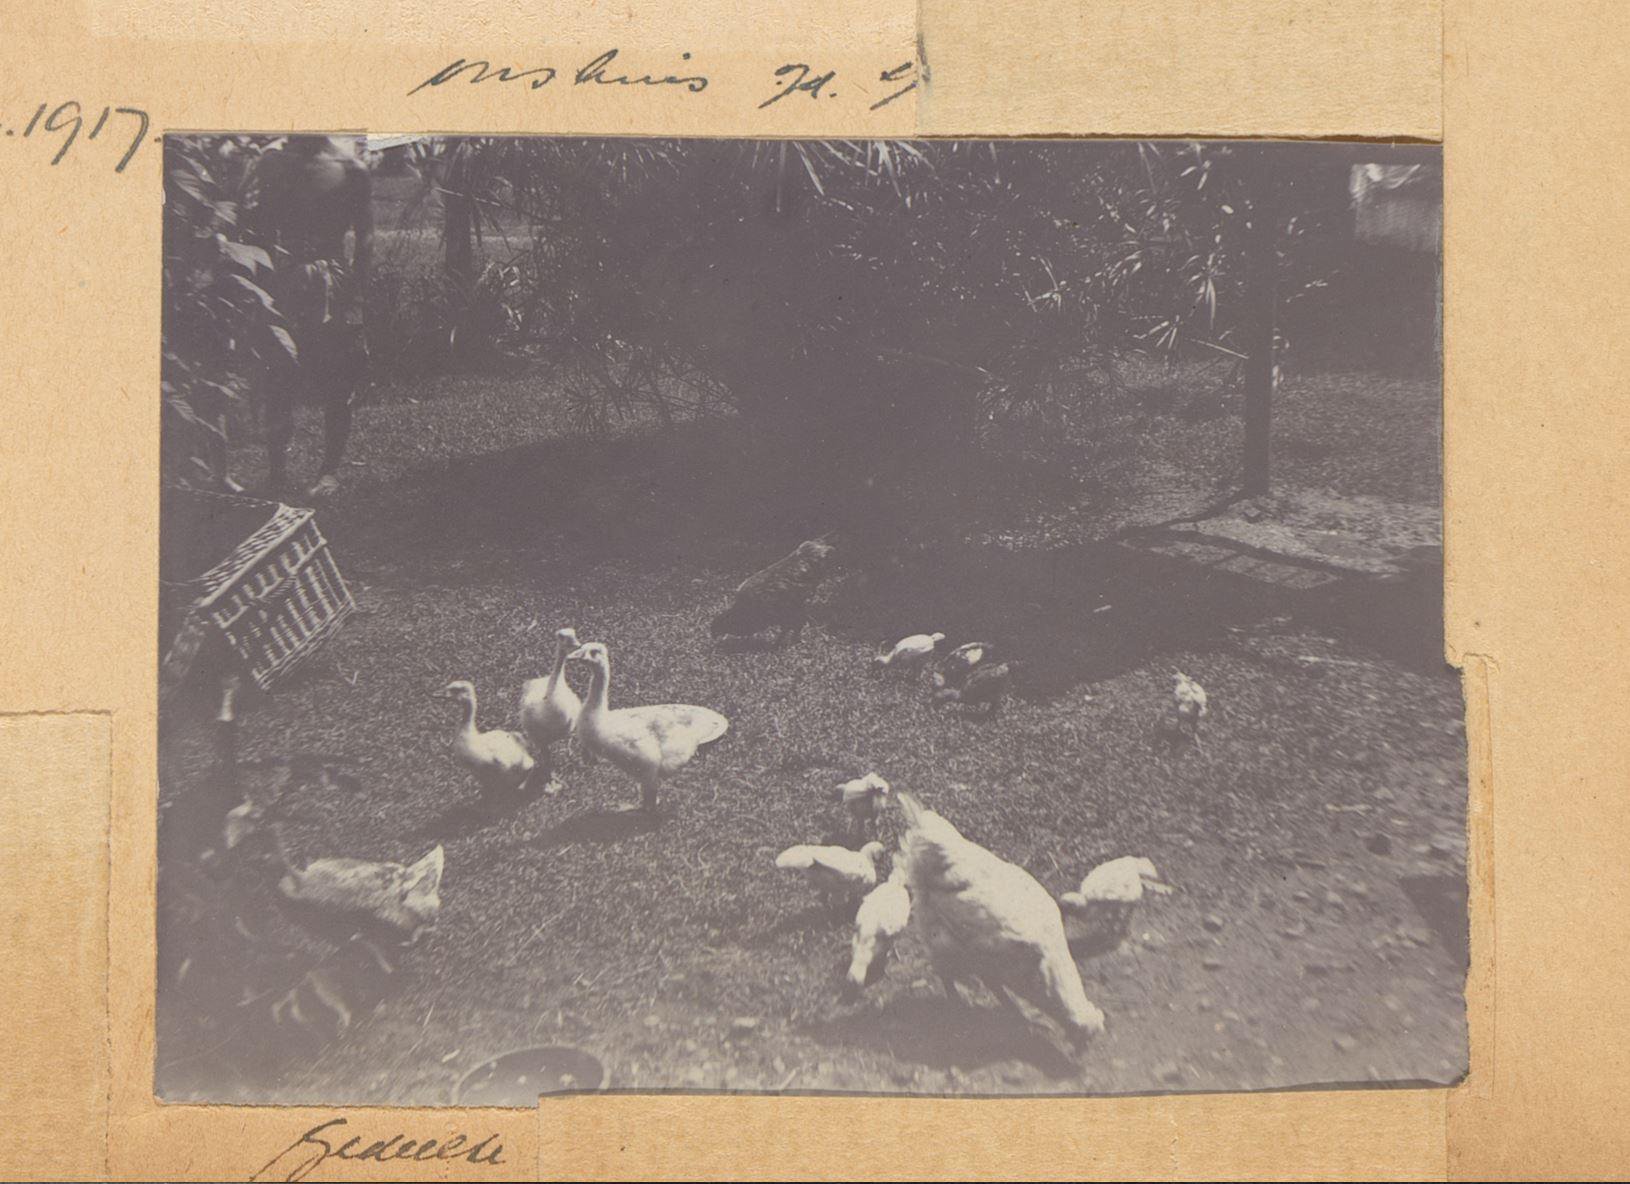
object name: photograph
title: Pluimvee in een tuin in Nederlands-Indië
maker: Anonymous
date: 1917-1918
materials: photographic support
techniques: daylight paper print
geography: dutch east indies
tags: fowl (cock, hen, chicken, etc.), dutch east indies, the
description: Onderdeel van Familiealbum met foto's van een familie in de voormalige kolonie Nederlands-Indië en van een suikerfabriek in Purworejo.